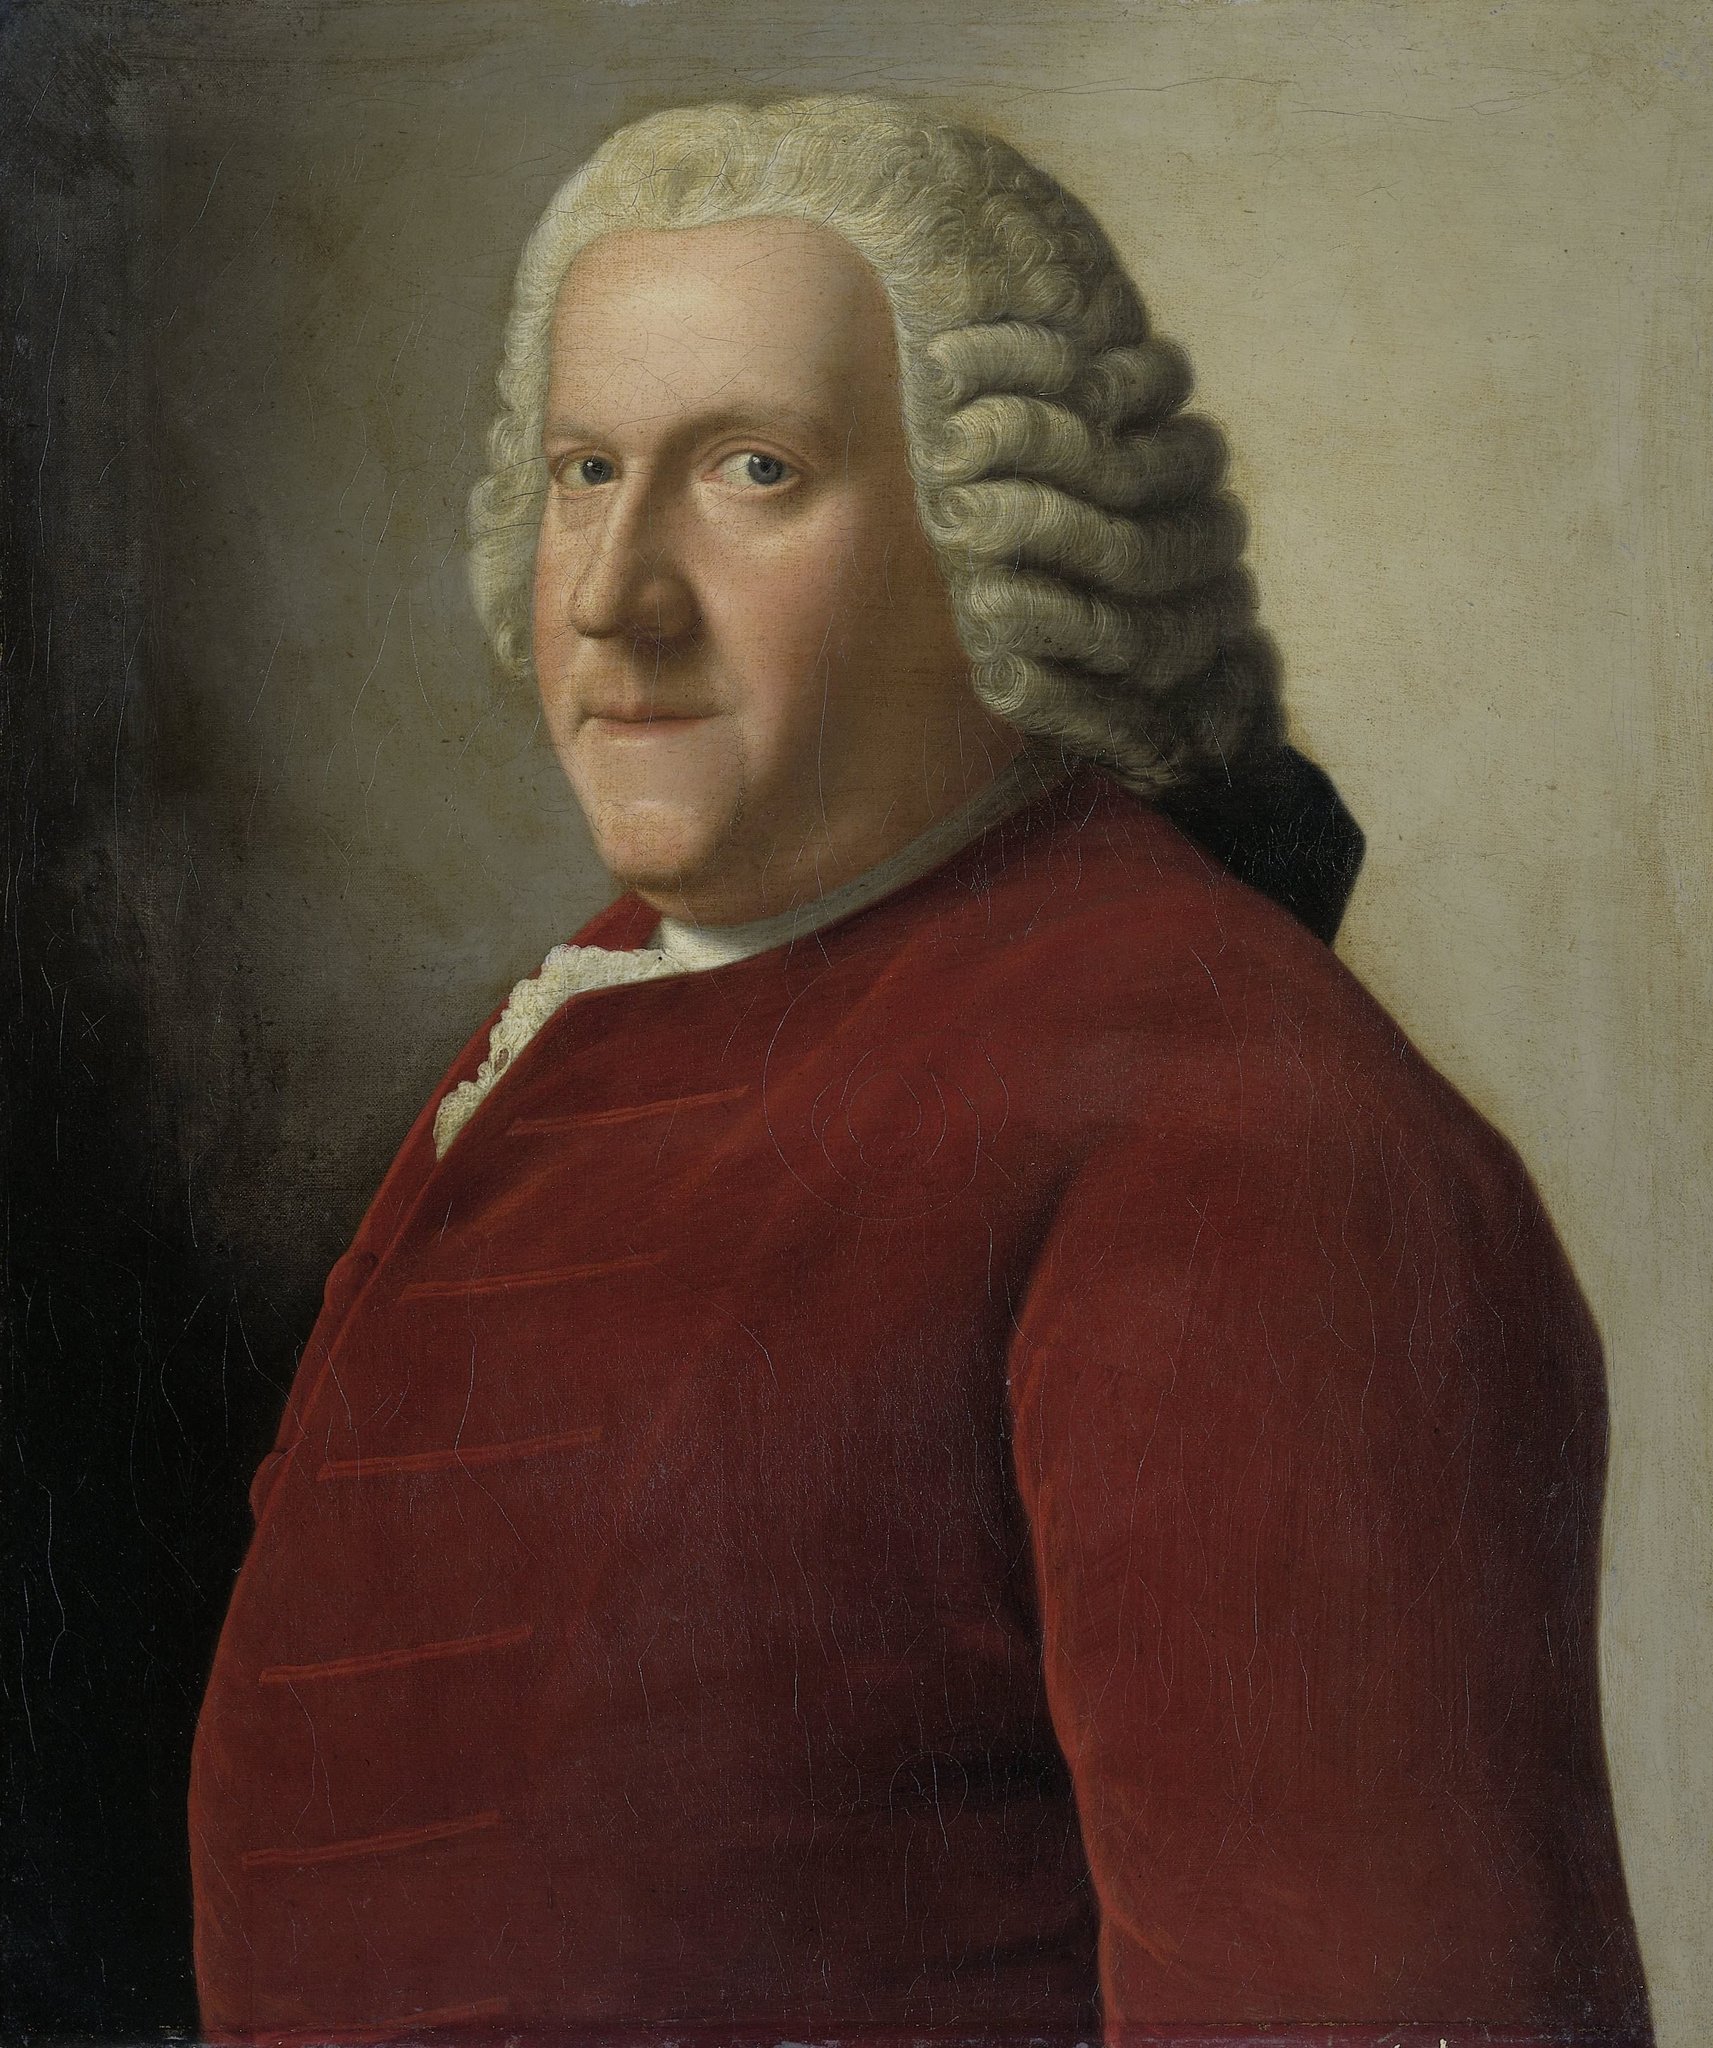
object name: painting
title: Willem Bentinck (1704-1774). Diplomat in the Service of Willem IV, the Regentess Anna and Willem V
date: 1755-1756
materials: canvas, oil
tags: diplomaat, willem bentinck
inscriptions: inscription: ‘Cap.tn Bentinck's Father’, inscription: ‘Honorable William Bentinck, died 1774, married 1732 to Charlotte Sophie Countess Aldenburg’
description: Willem Bentinck van Rhoon, copy after J.E. Liotard (c. 1755-1756). The Dutch aristocrat Bentinck (1704-1774) played an important part in gaining William IV's appointment in all the country's provinces. As an advisor, he exercised a major influence on the stadholder's policies, especially on foreign affairs. After the death of William IV in 1751 Bentinck was forced into the background by the advisors of Princess-Regent Anna.